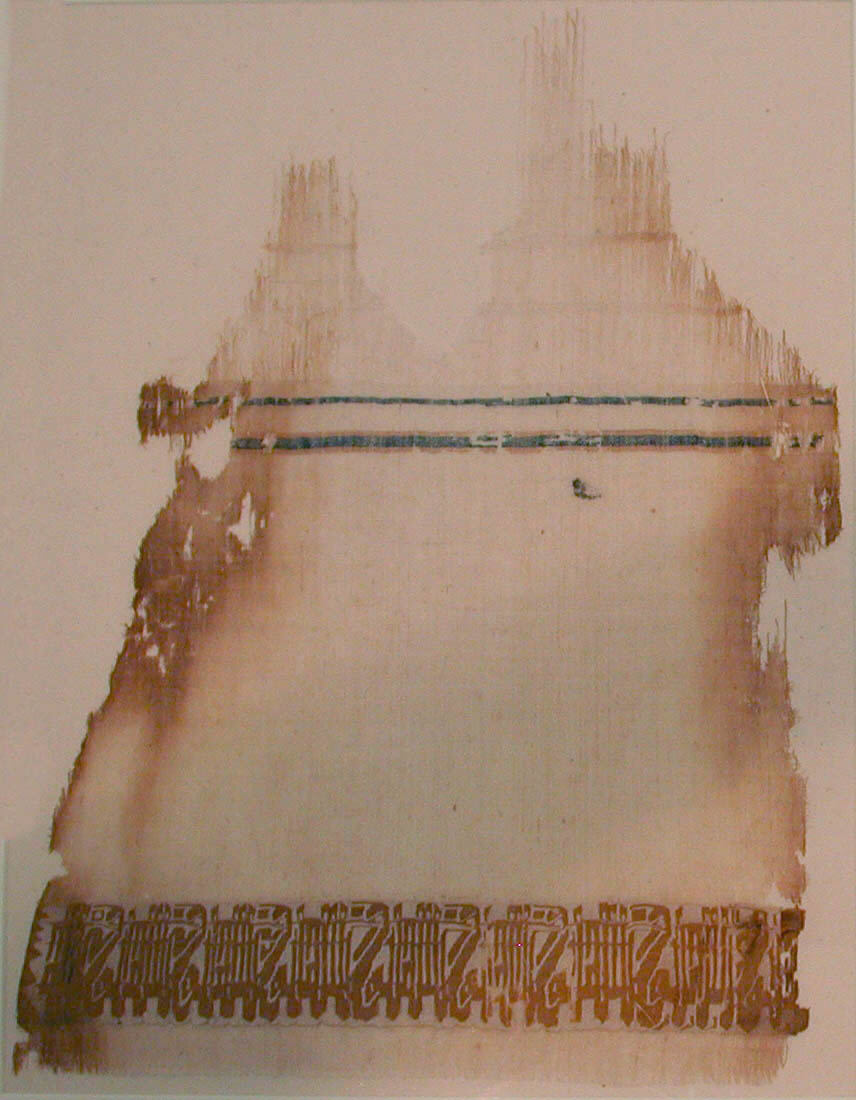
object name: textile fragment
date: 901-1100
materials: linen, silk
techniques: weave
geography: egypt